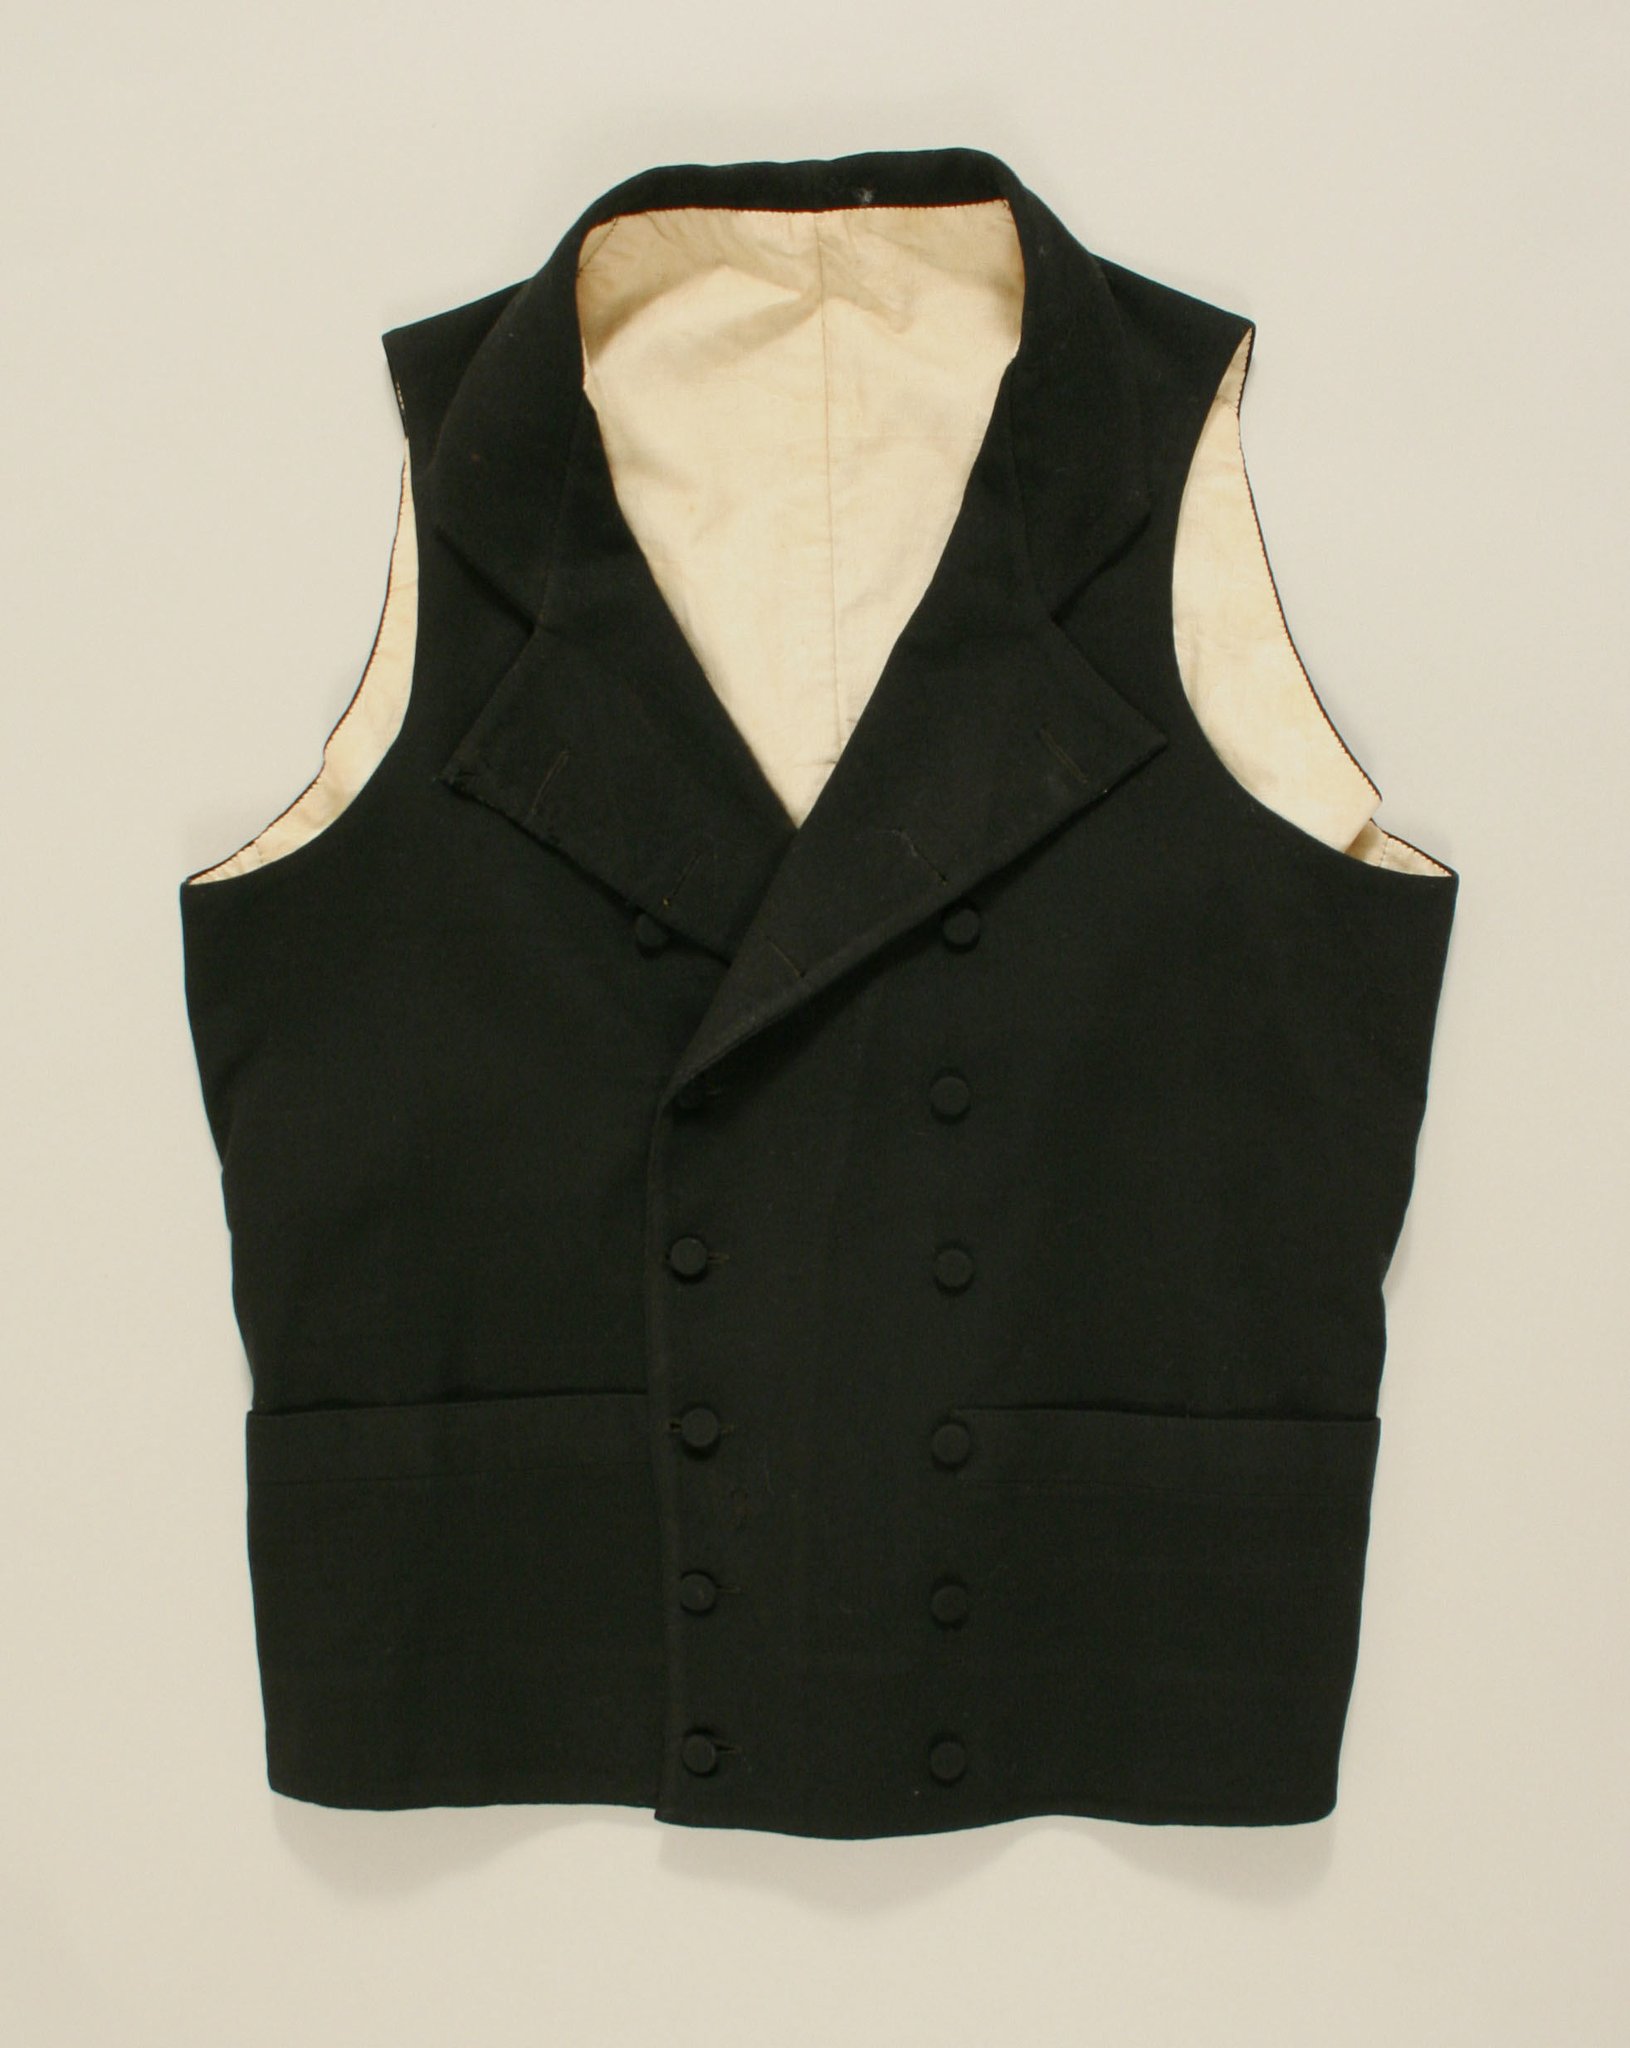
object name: waistcoat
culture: british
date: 1801-1825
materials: wool